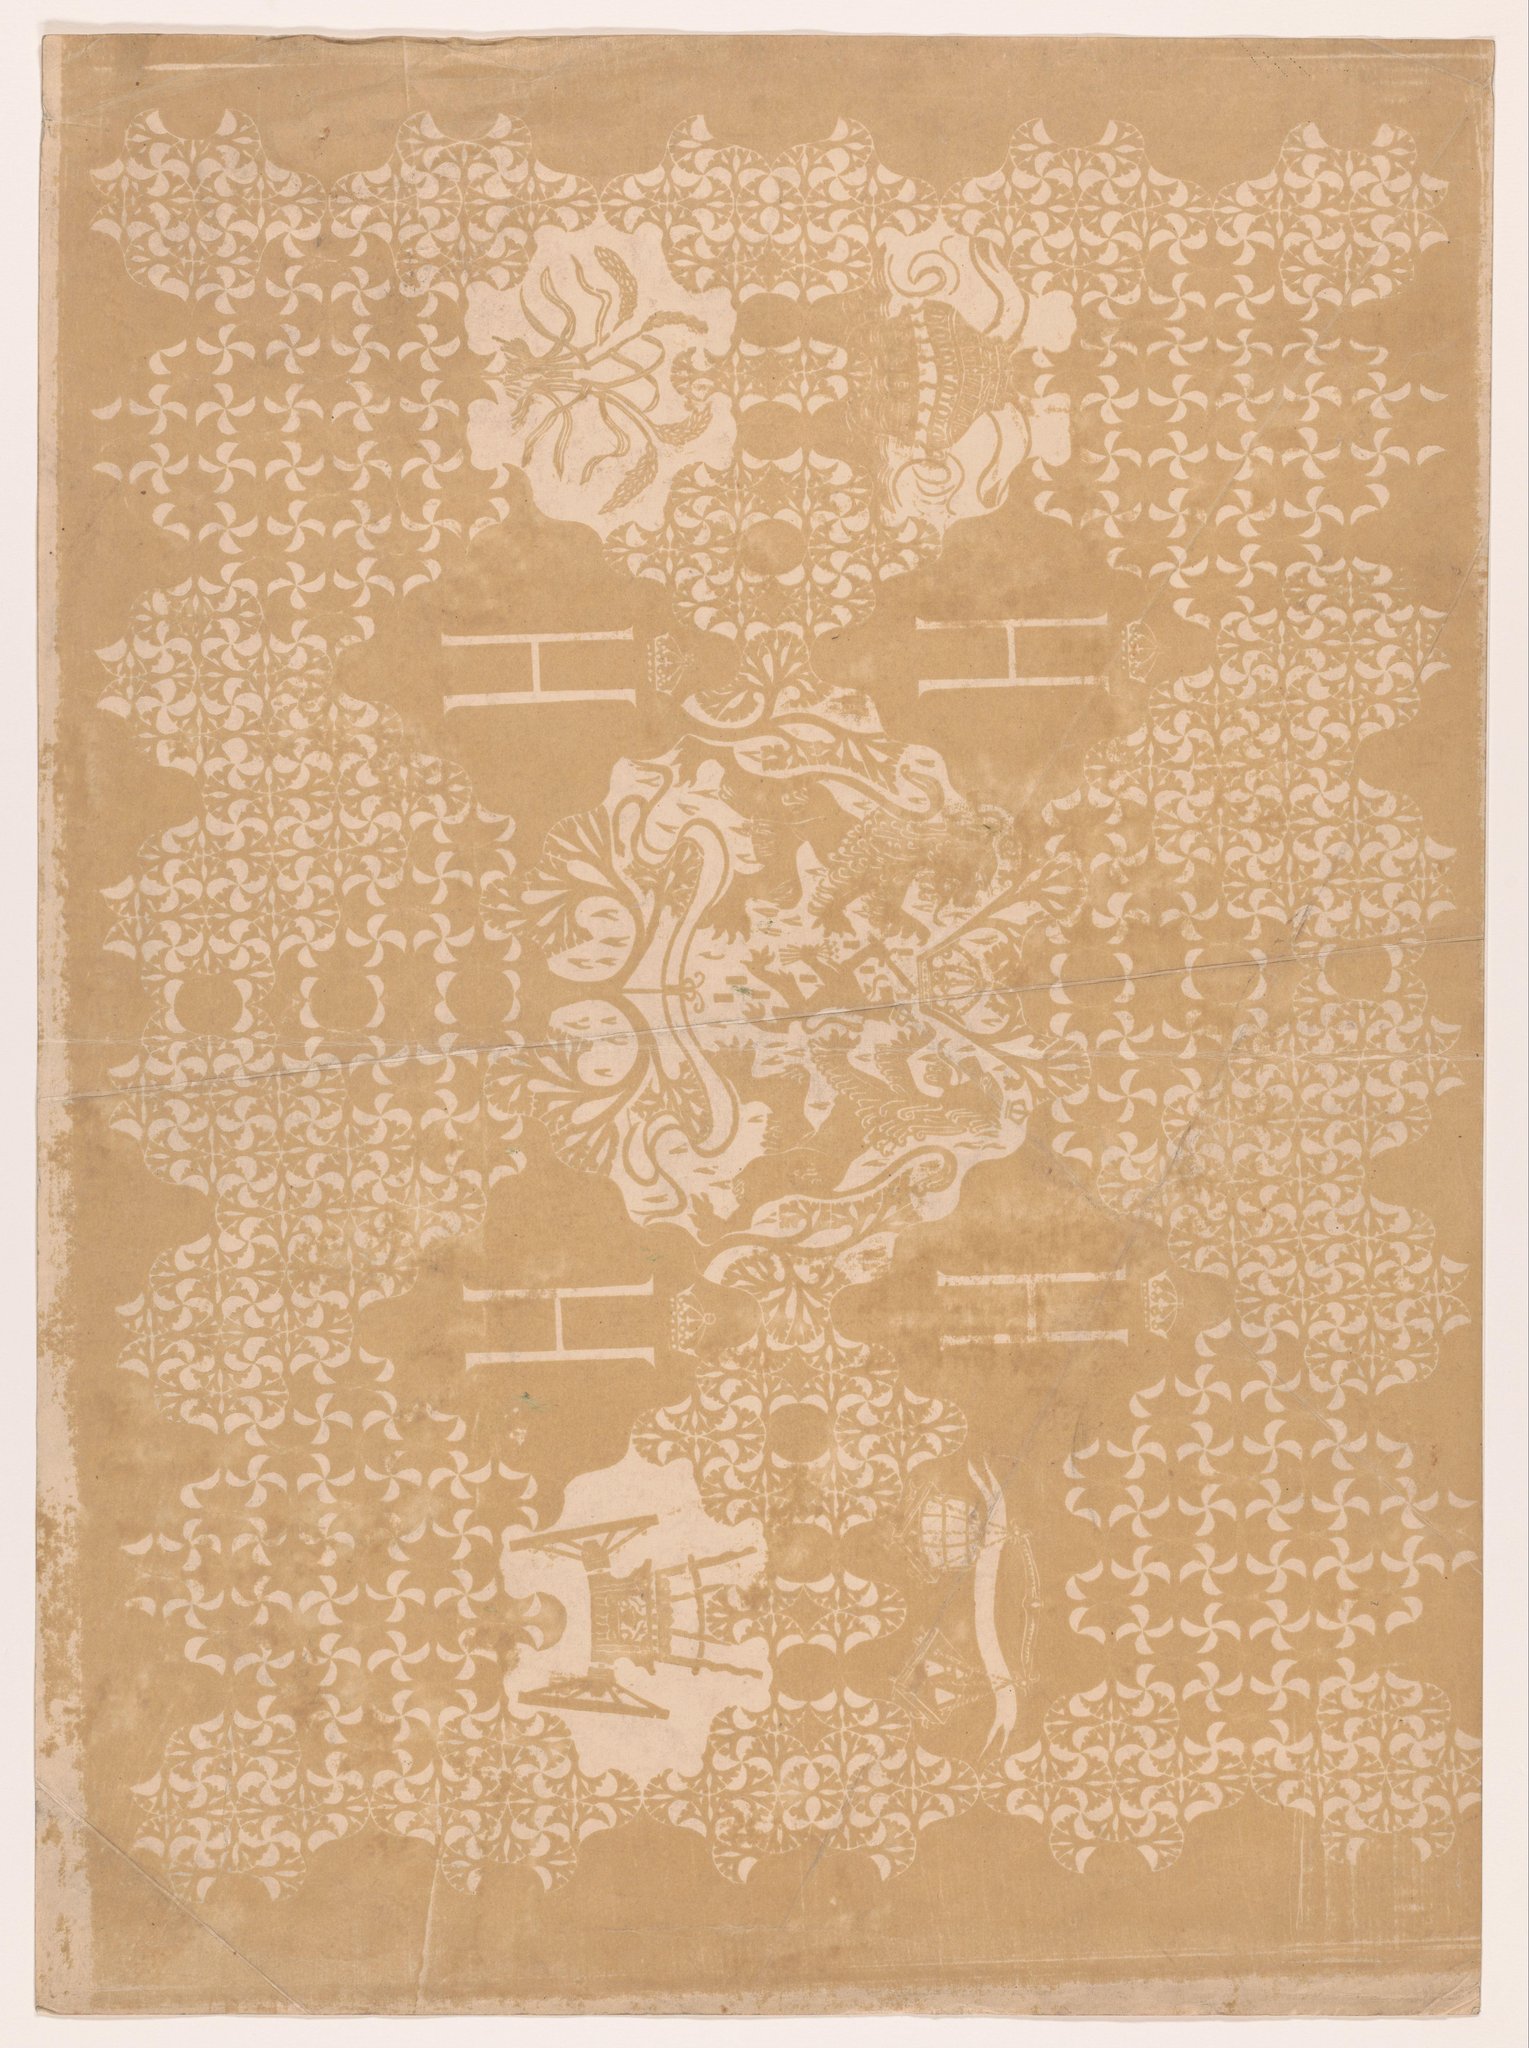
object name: print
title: Blad met ornamenten, boot, wagen en wapen van Nederland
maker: carel adolph lion cachet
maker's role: draughtsman, print maker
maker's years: 1864-1945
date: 1874-1945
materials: paper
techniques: woodcut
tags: coat of arms (as symbol of the state, etc.), ornaments ~ art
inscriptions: collector's mark: Lugt 2228